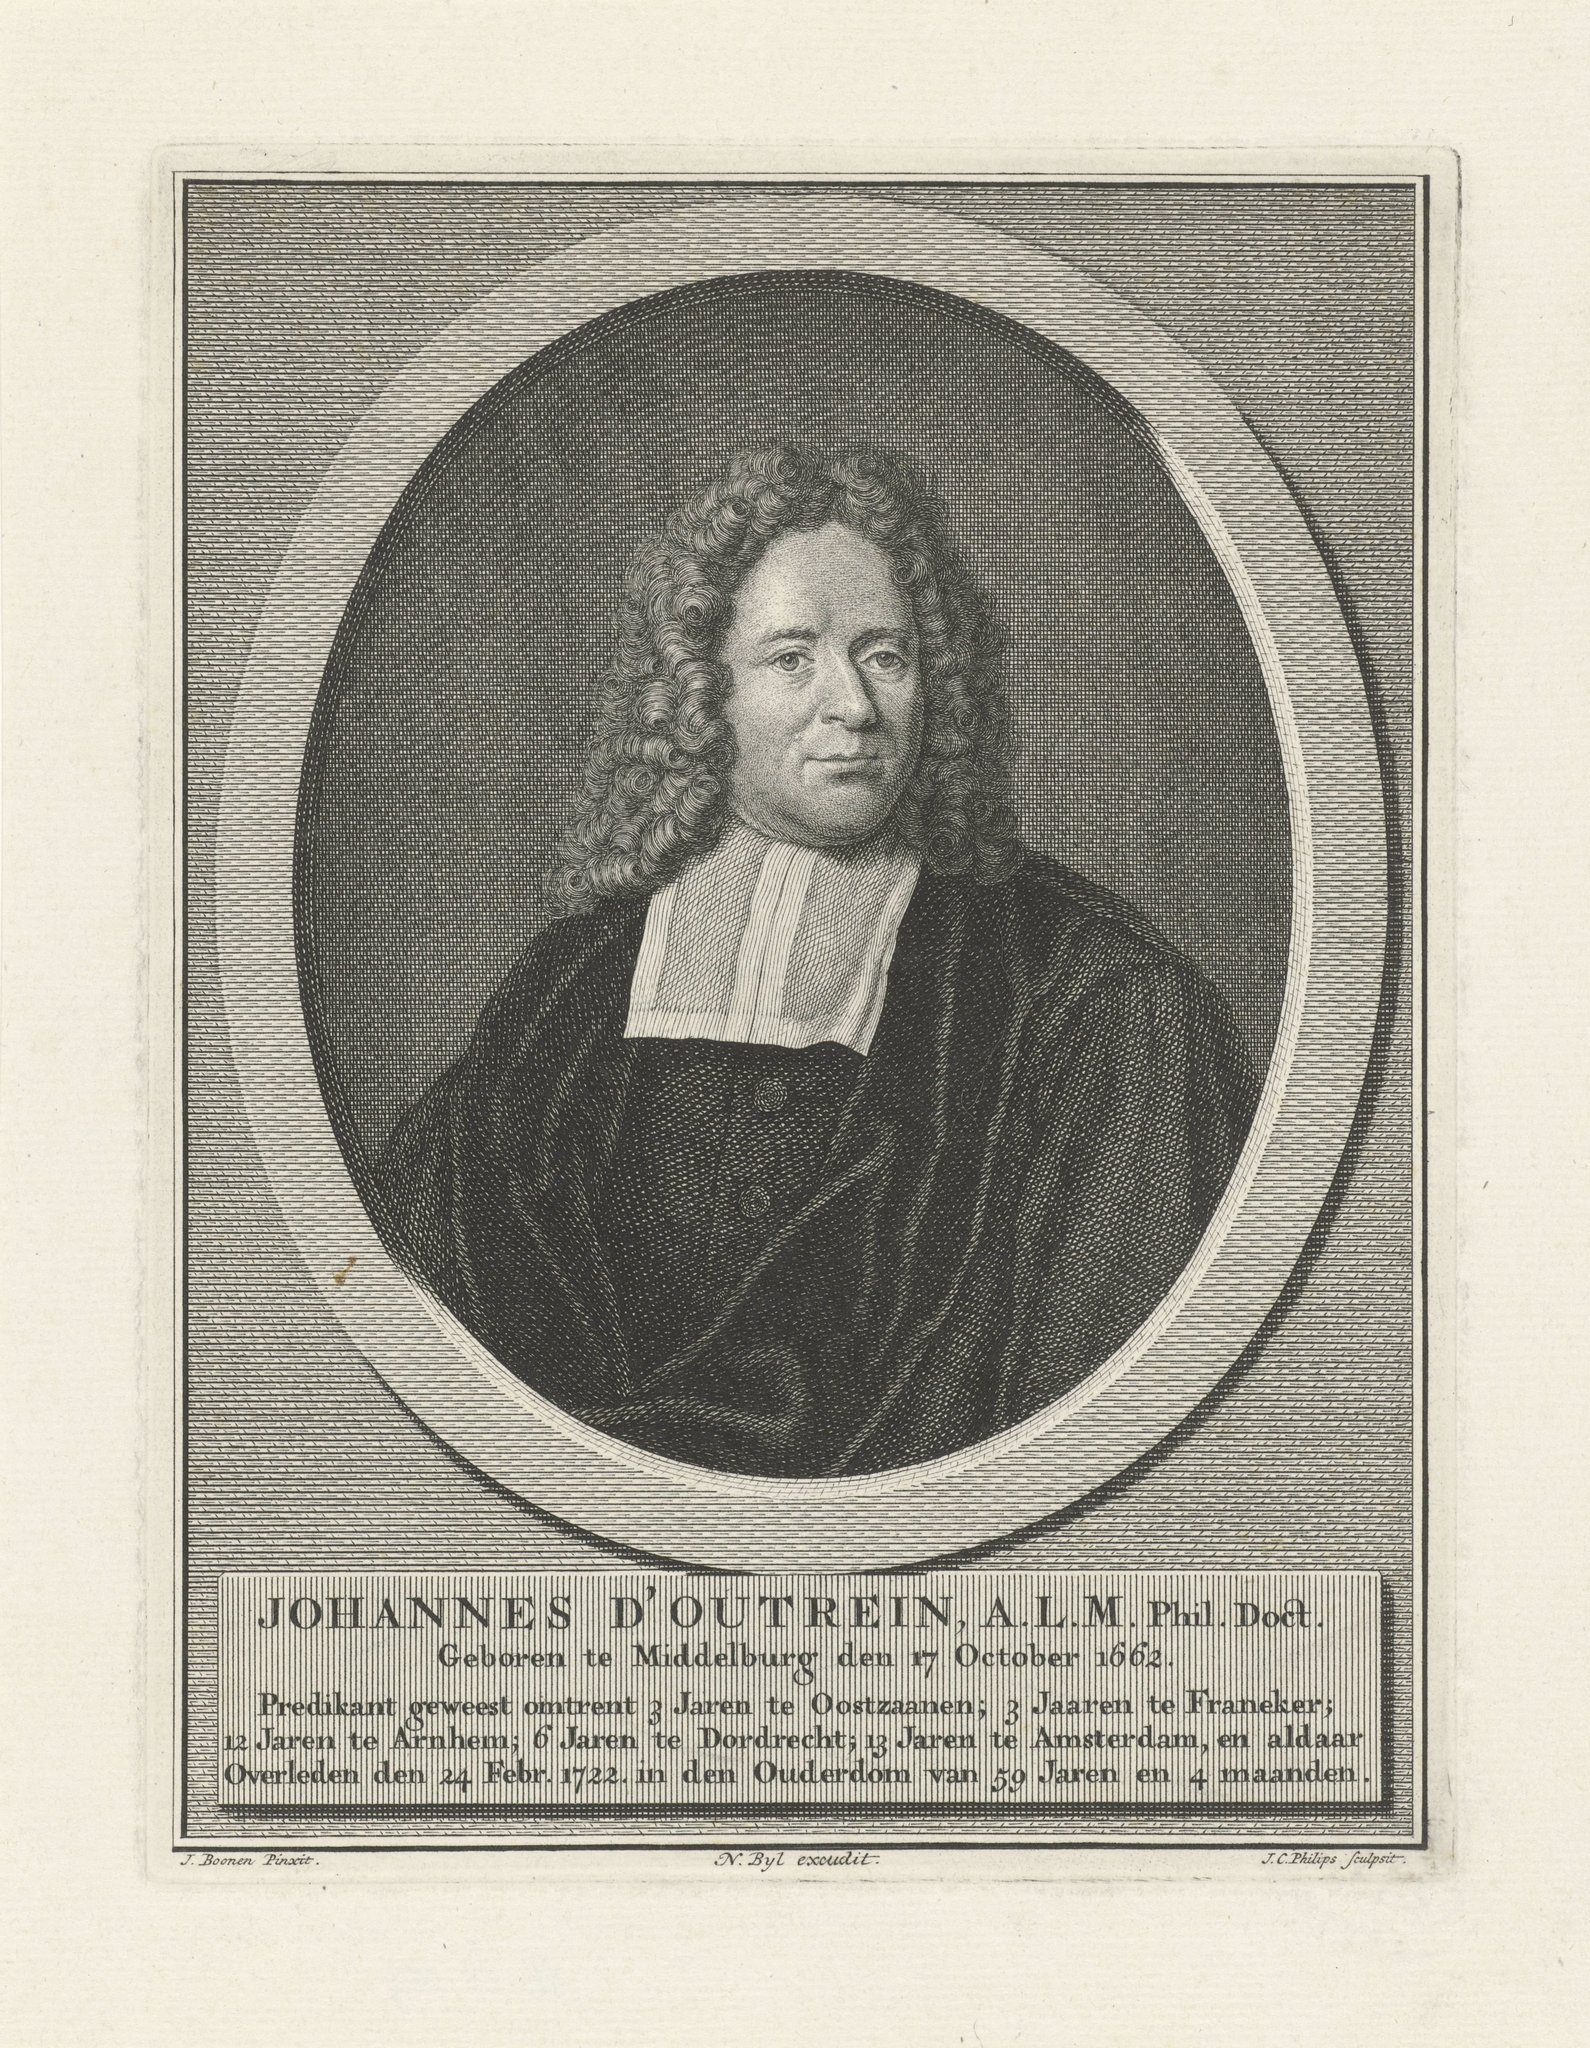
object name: print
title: Portret van de predikant Johannes d'Outrein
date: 1736-1775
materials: paper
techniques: engraving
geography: amsterdam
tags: middelburg, amsterdam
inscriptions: collector's mark: Lugt 240